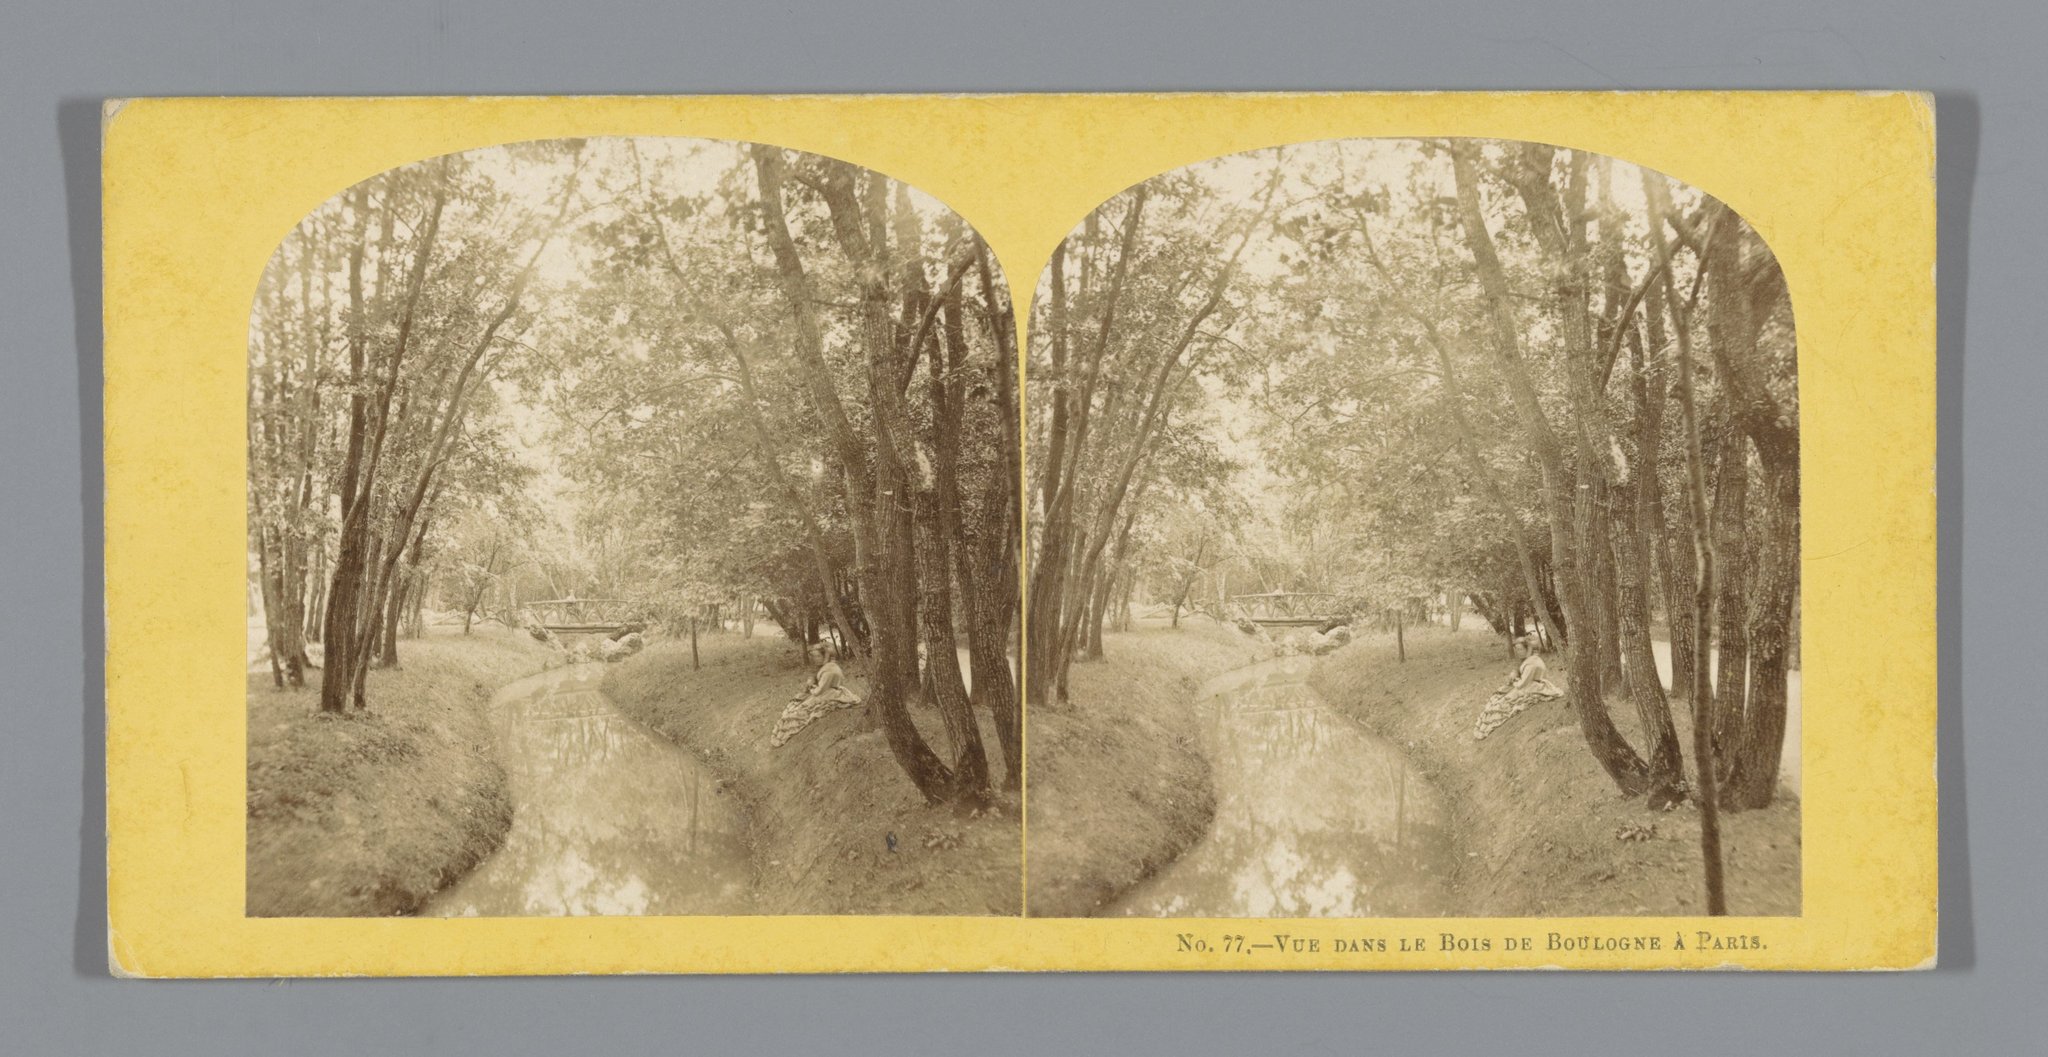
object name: stereograph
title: Beek in het Bois de Boulogne te Parijs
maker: Anonymous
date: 1850-1875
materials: cardboard, photographic support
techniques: albumen print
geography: bois de boulogne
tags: brook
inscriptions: number: ‘No. 77.’